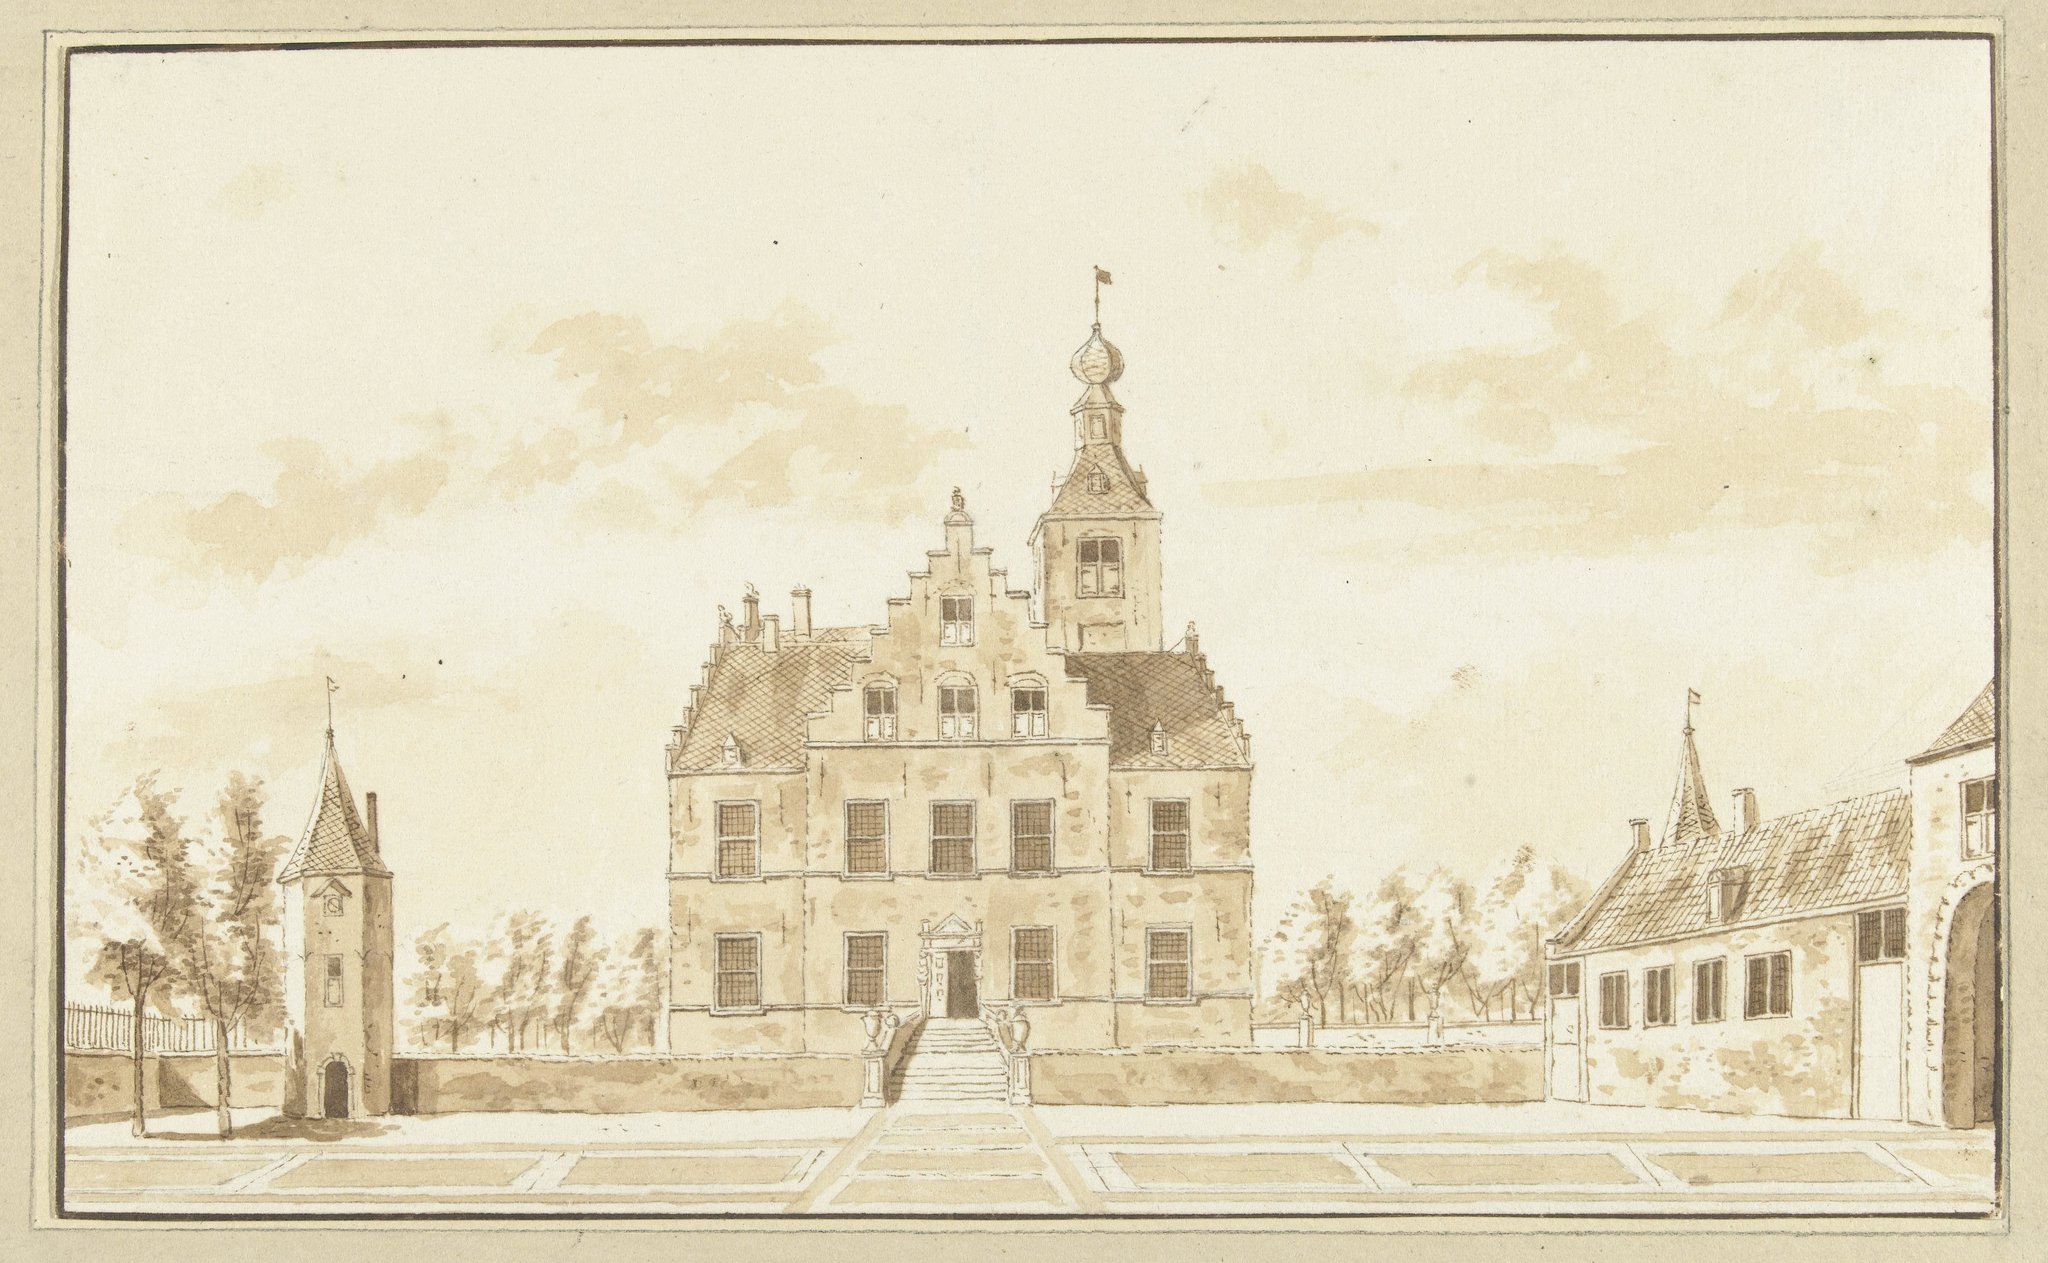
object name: drawing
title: Huis Zuilestein of Zuylestein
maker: abraham rademaker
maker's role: draughtsman, print maker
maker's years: 1676-1735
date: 1685-1735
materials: ink, paper, pencil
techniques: brush, pen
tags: castle